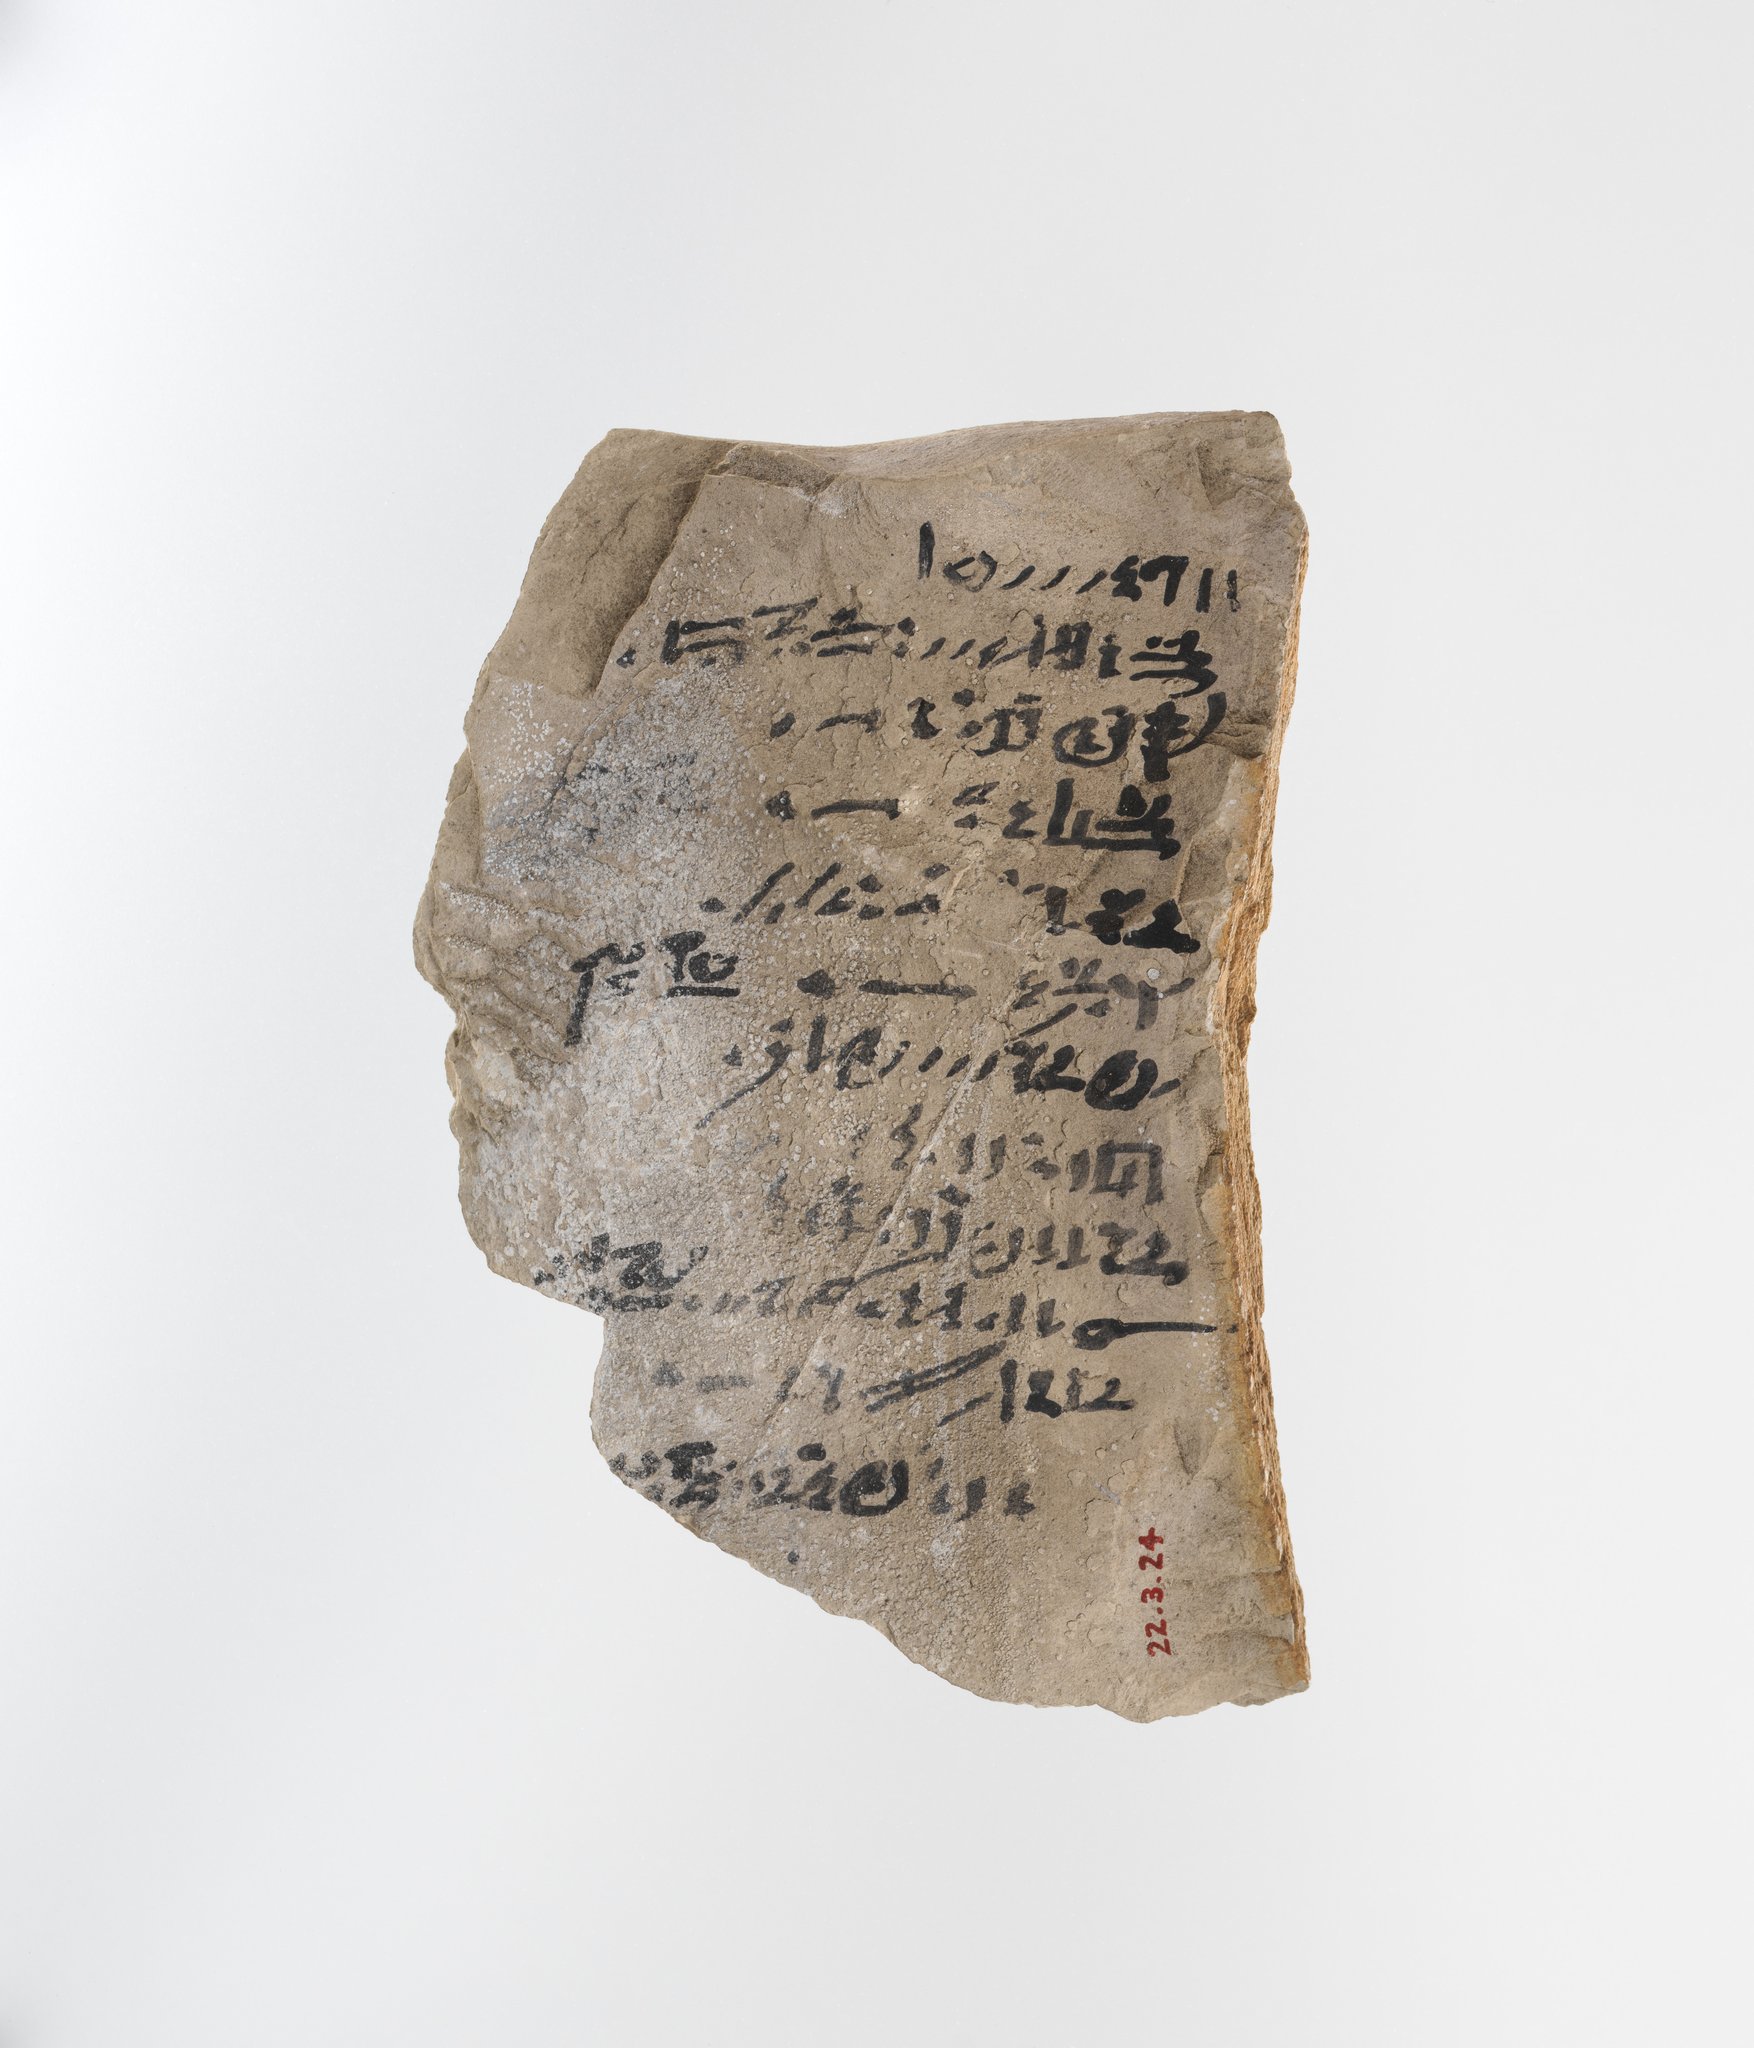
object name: ostracon, hieratic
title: Ostracon with hieratic inscription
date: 1295-525 BCE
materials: ink, limestone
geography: egypt